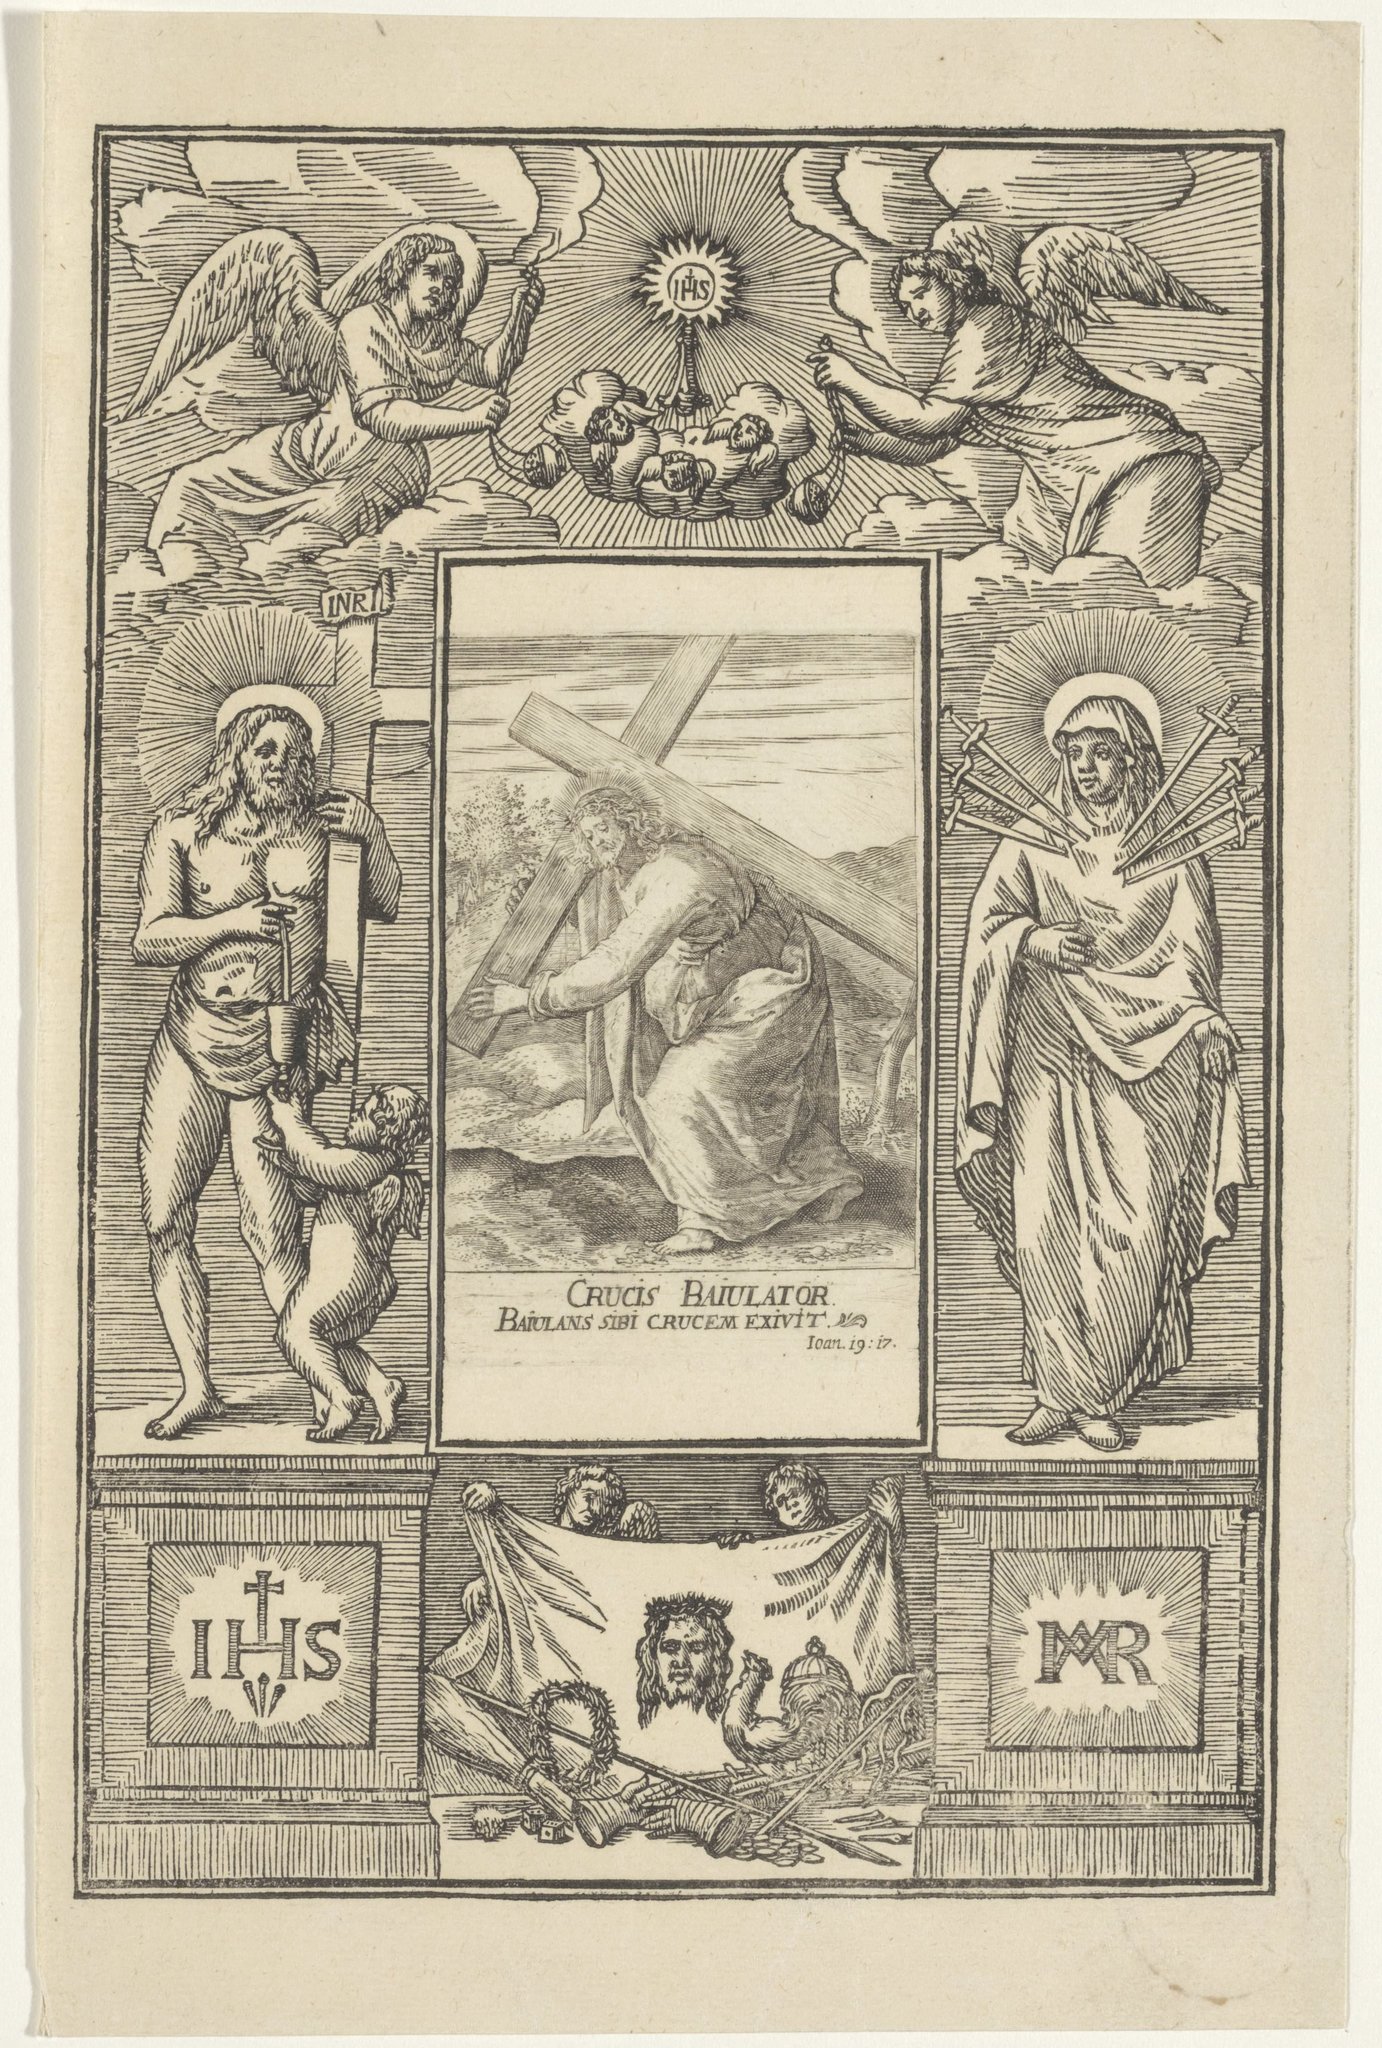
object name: print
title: Kruisdraging van Christus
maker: Anonymous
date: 1600-1699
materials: paper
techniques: engraving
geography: netherlands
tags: lance ~ instruments of the passion, cherubs, i.e. children's heads with wings, mary pierced by seven swords, single instruments of the passion, crown of thorns ~ instruments of the passion, nails ~ instruments of the passion, angels, carrying of the cross: christ bearing the cross, alone or with the help of others (e.g. simon the cyrenian), 'vera icon', 'sudarium', veronica-portrait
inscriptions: collector's mark: Lugt 240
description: Christus draagt het kruis. In de ondermarge twee regels Latijnse tekst. Geheel in een omlijsting met links Christus met een kruis, rechts Maria doorstoken met zeven zwaarden, midden boven engelen en cherubijnen en midden onder de lijdenswerktuigen van Christus.